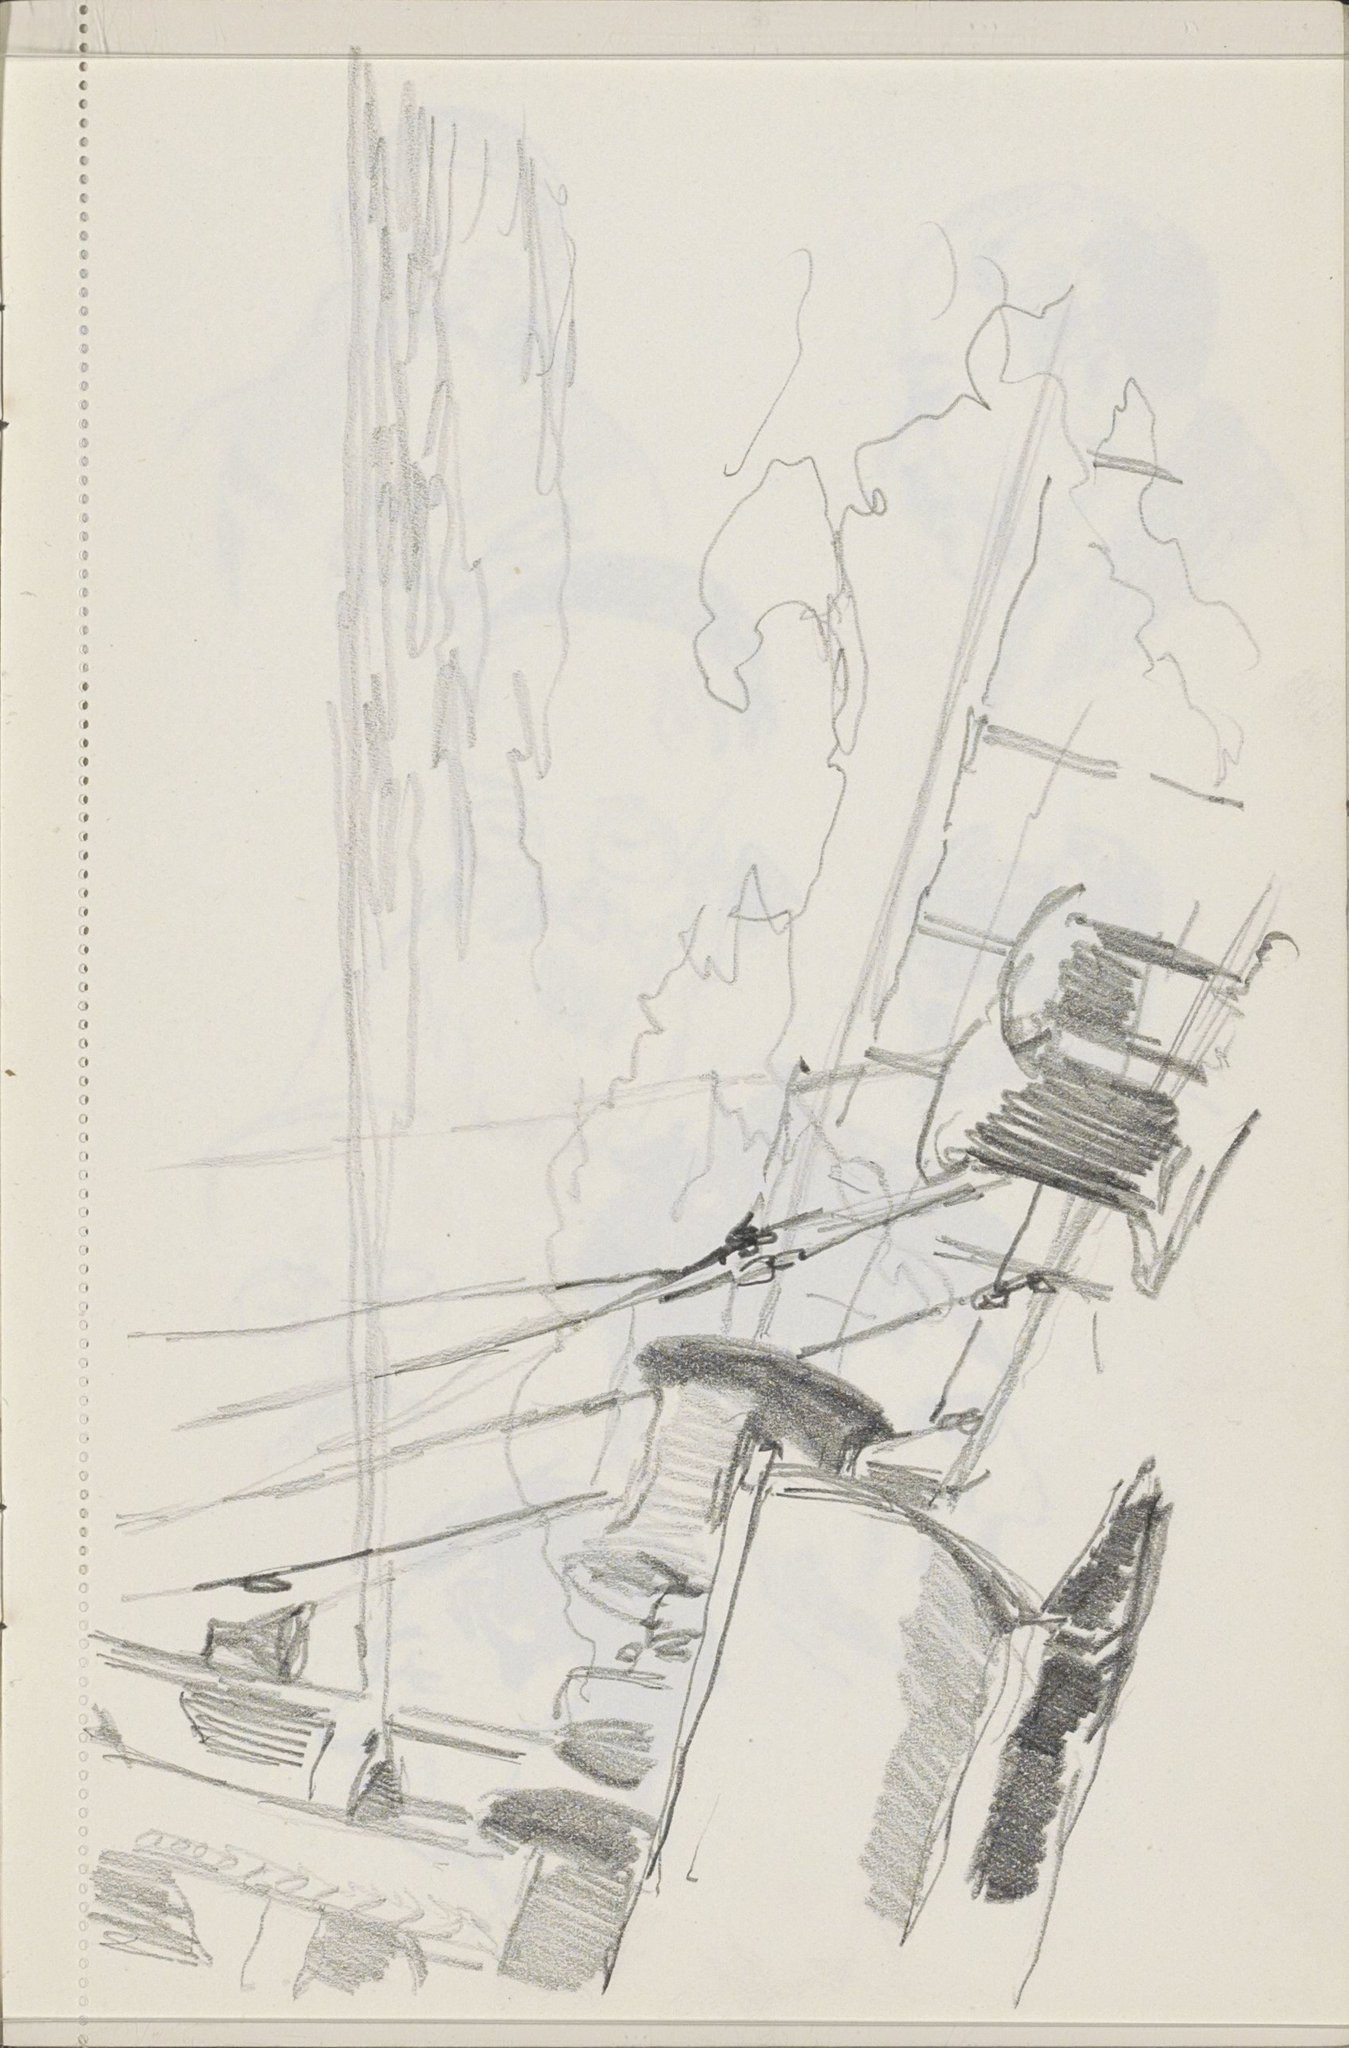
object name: sketchbook leaf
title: Uitzicht op zee vanaf het dek van een schip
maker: cornelis vreedenburgh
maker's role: draughtsman, print maker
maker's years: 1880-1946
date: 1936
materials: paper, pencil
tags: parts of ship's exterior: deck, sea (seascape)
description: Blad 22 recto uit een schetsboek met 73 bladen.